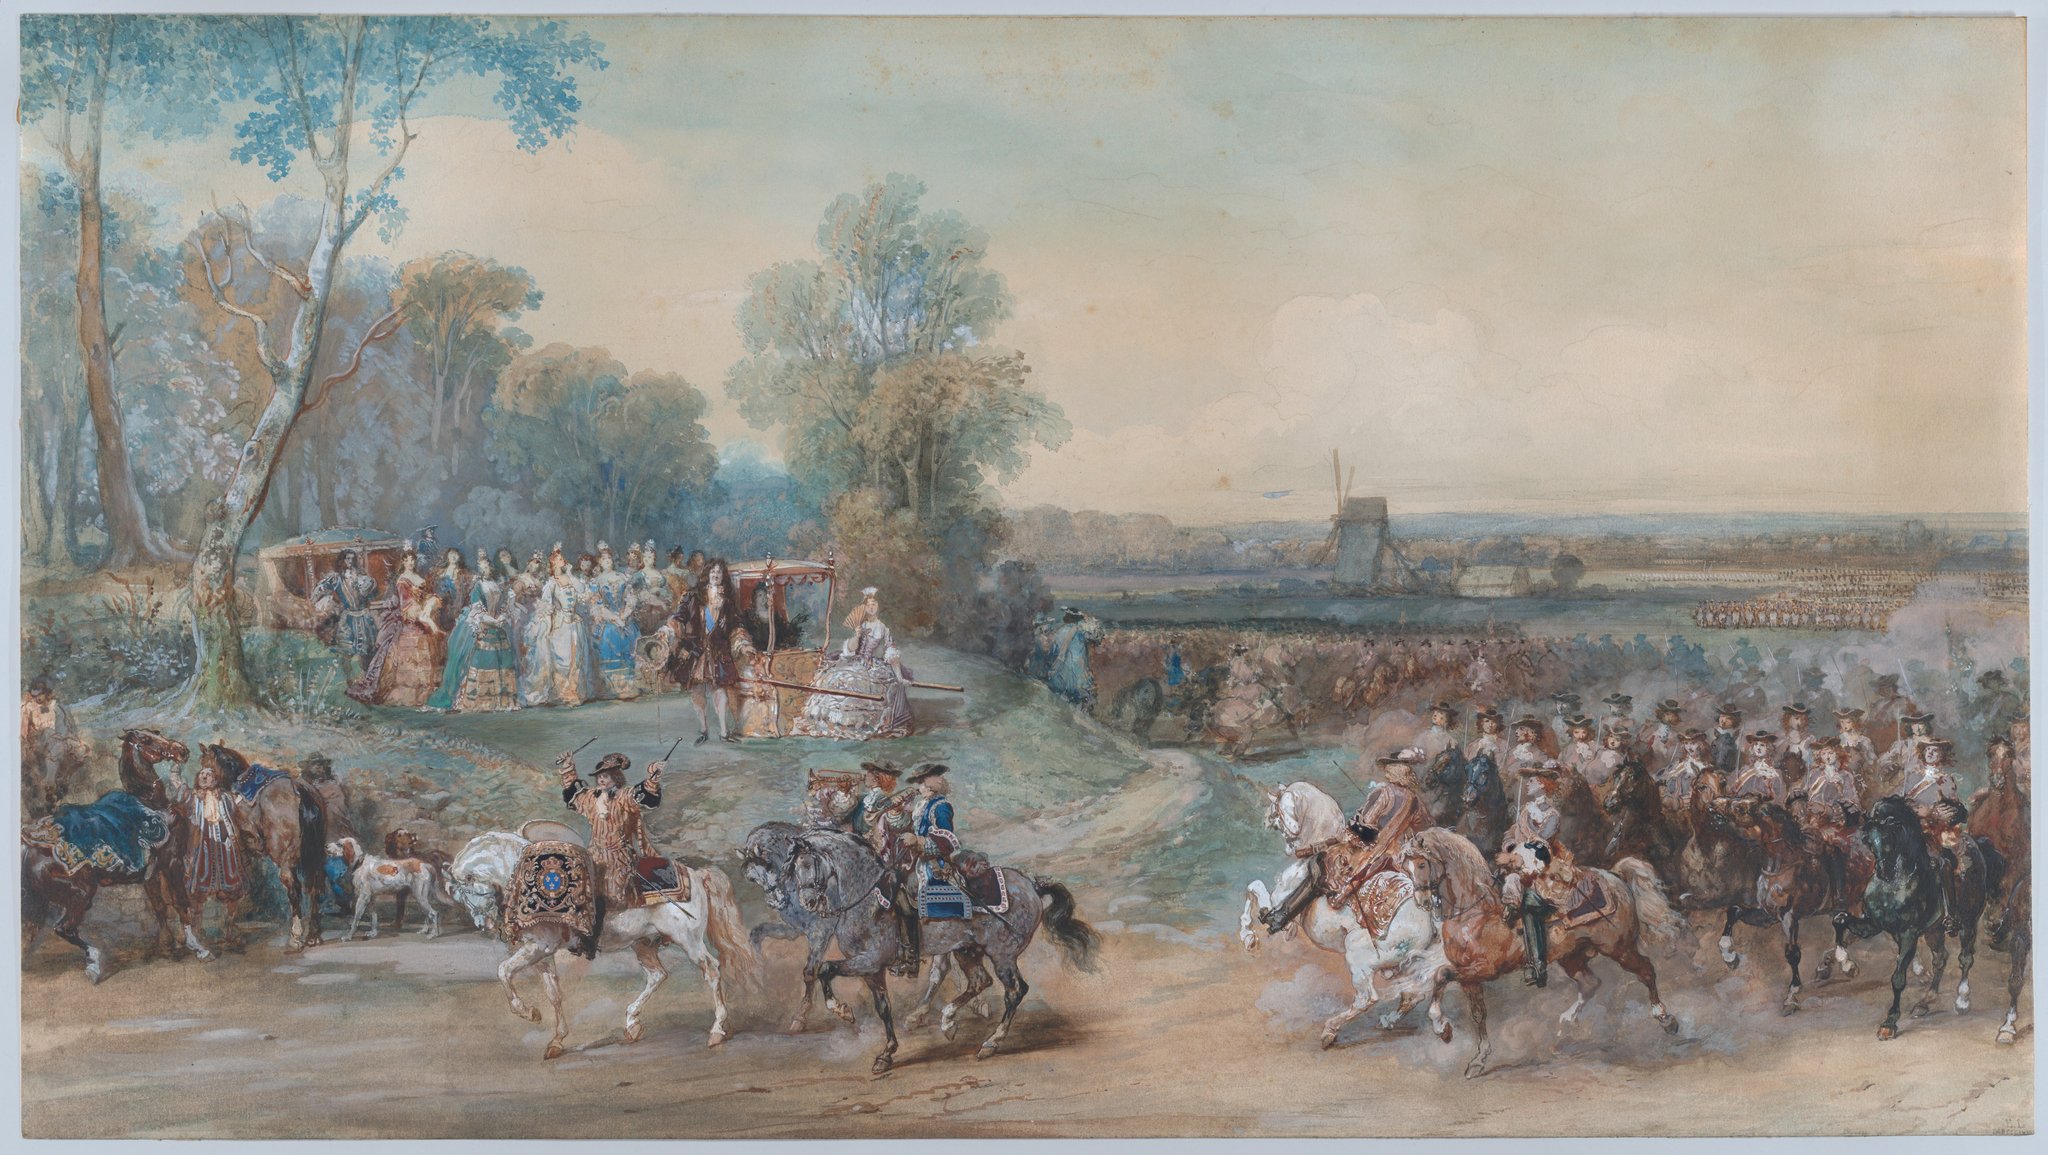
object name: drawing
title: Camp de Compiègne, 1698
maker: eugène-louis lami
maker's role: artist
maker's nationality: french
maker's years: 1800-1890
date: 1860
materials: chalk, gouache, watercolor, paper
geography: france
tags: men,women,horses,trees